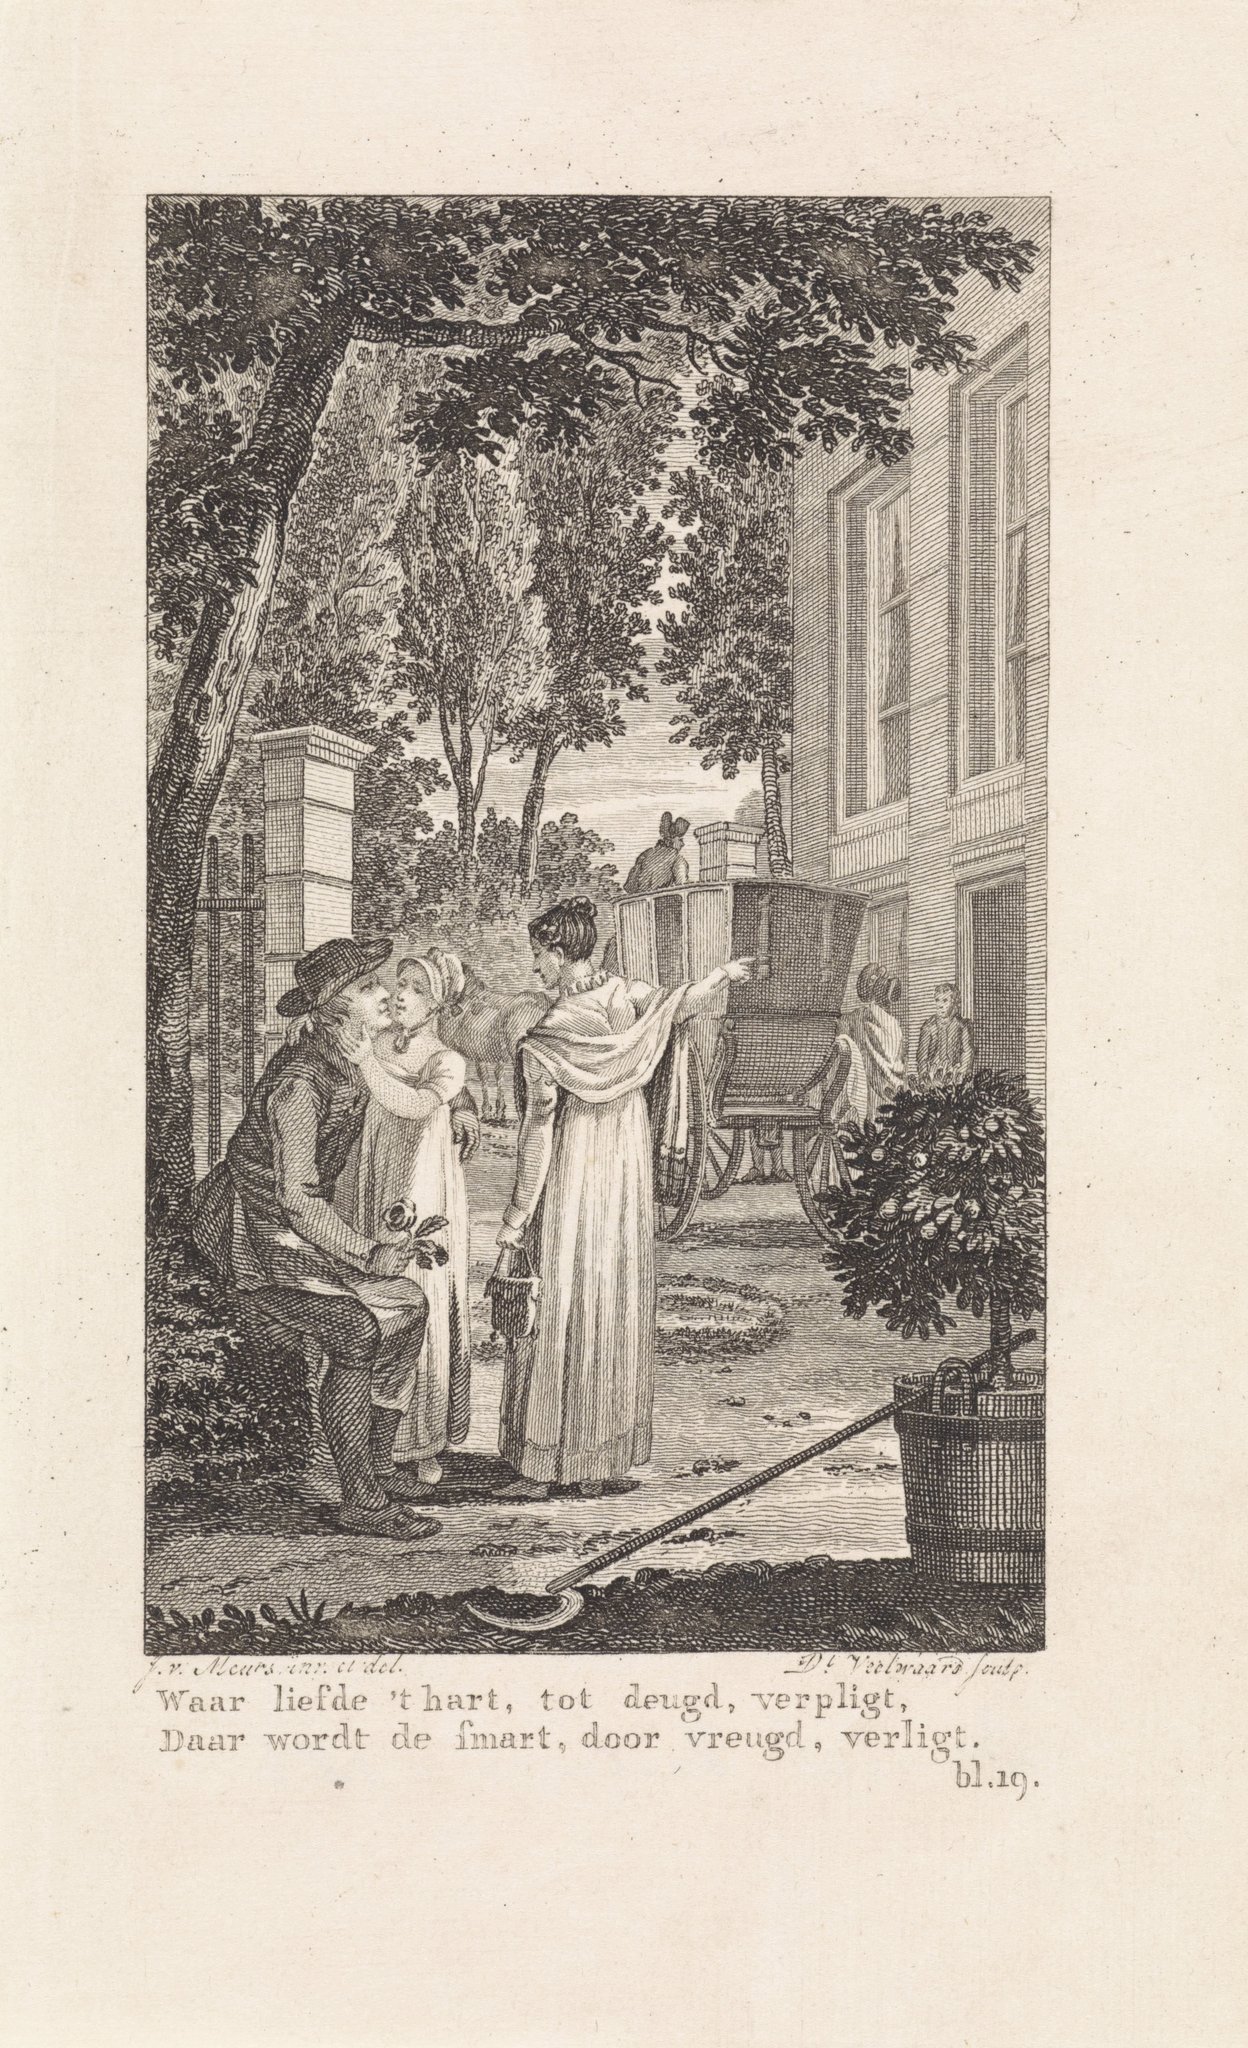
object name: print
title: Wijzende vrouw bij een liefdespaar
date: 1823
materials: paper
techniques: etching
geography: amsterdam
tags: (lovers) caressing each other, index finger forwards, pointing, indicating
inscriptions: collector's mark: Lugt 2228, collector's mark: Lugt 2760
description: Prent gebruikt als boekillustratie in: Hazeu Cornelisz., Johannes. De geschiedenis van Laura Guldenbeek: Een onderhoudend en leerzaam leesboek voor jonge lieden. Amsterdam: M.H. Helmig, 1823.